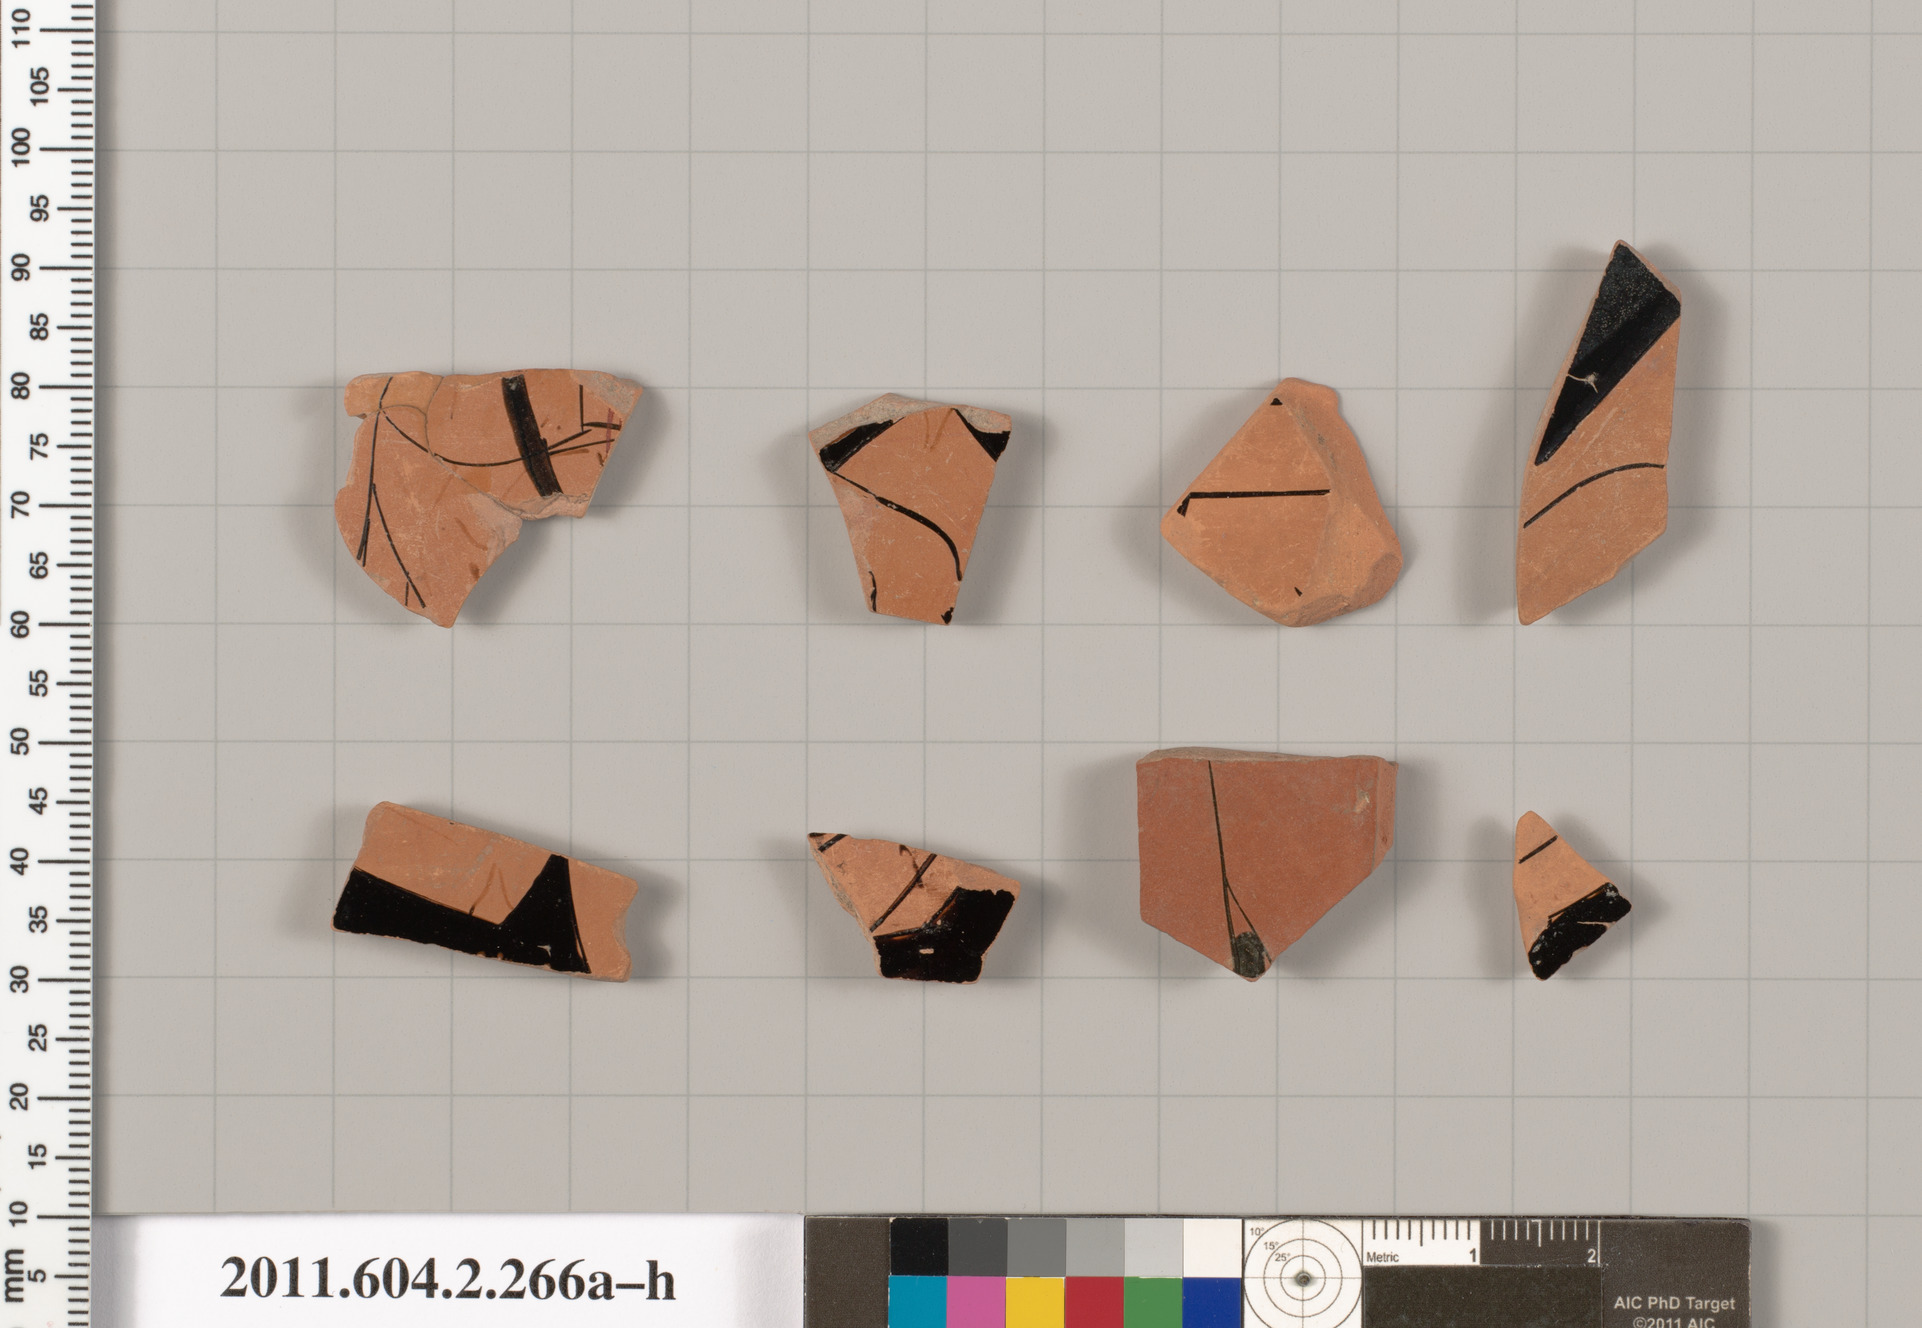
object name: stamnoi fragment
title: Terracotta fragments of stamnoi (jars)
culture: greek, attic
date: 490-470 BCE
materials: terracotta